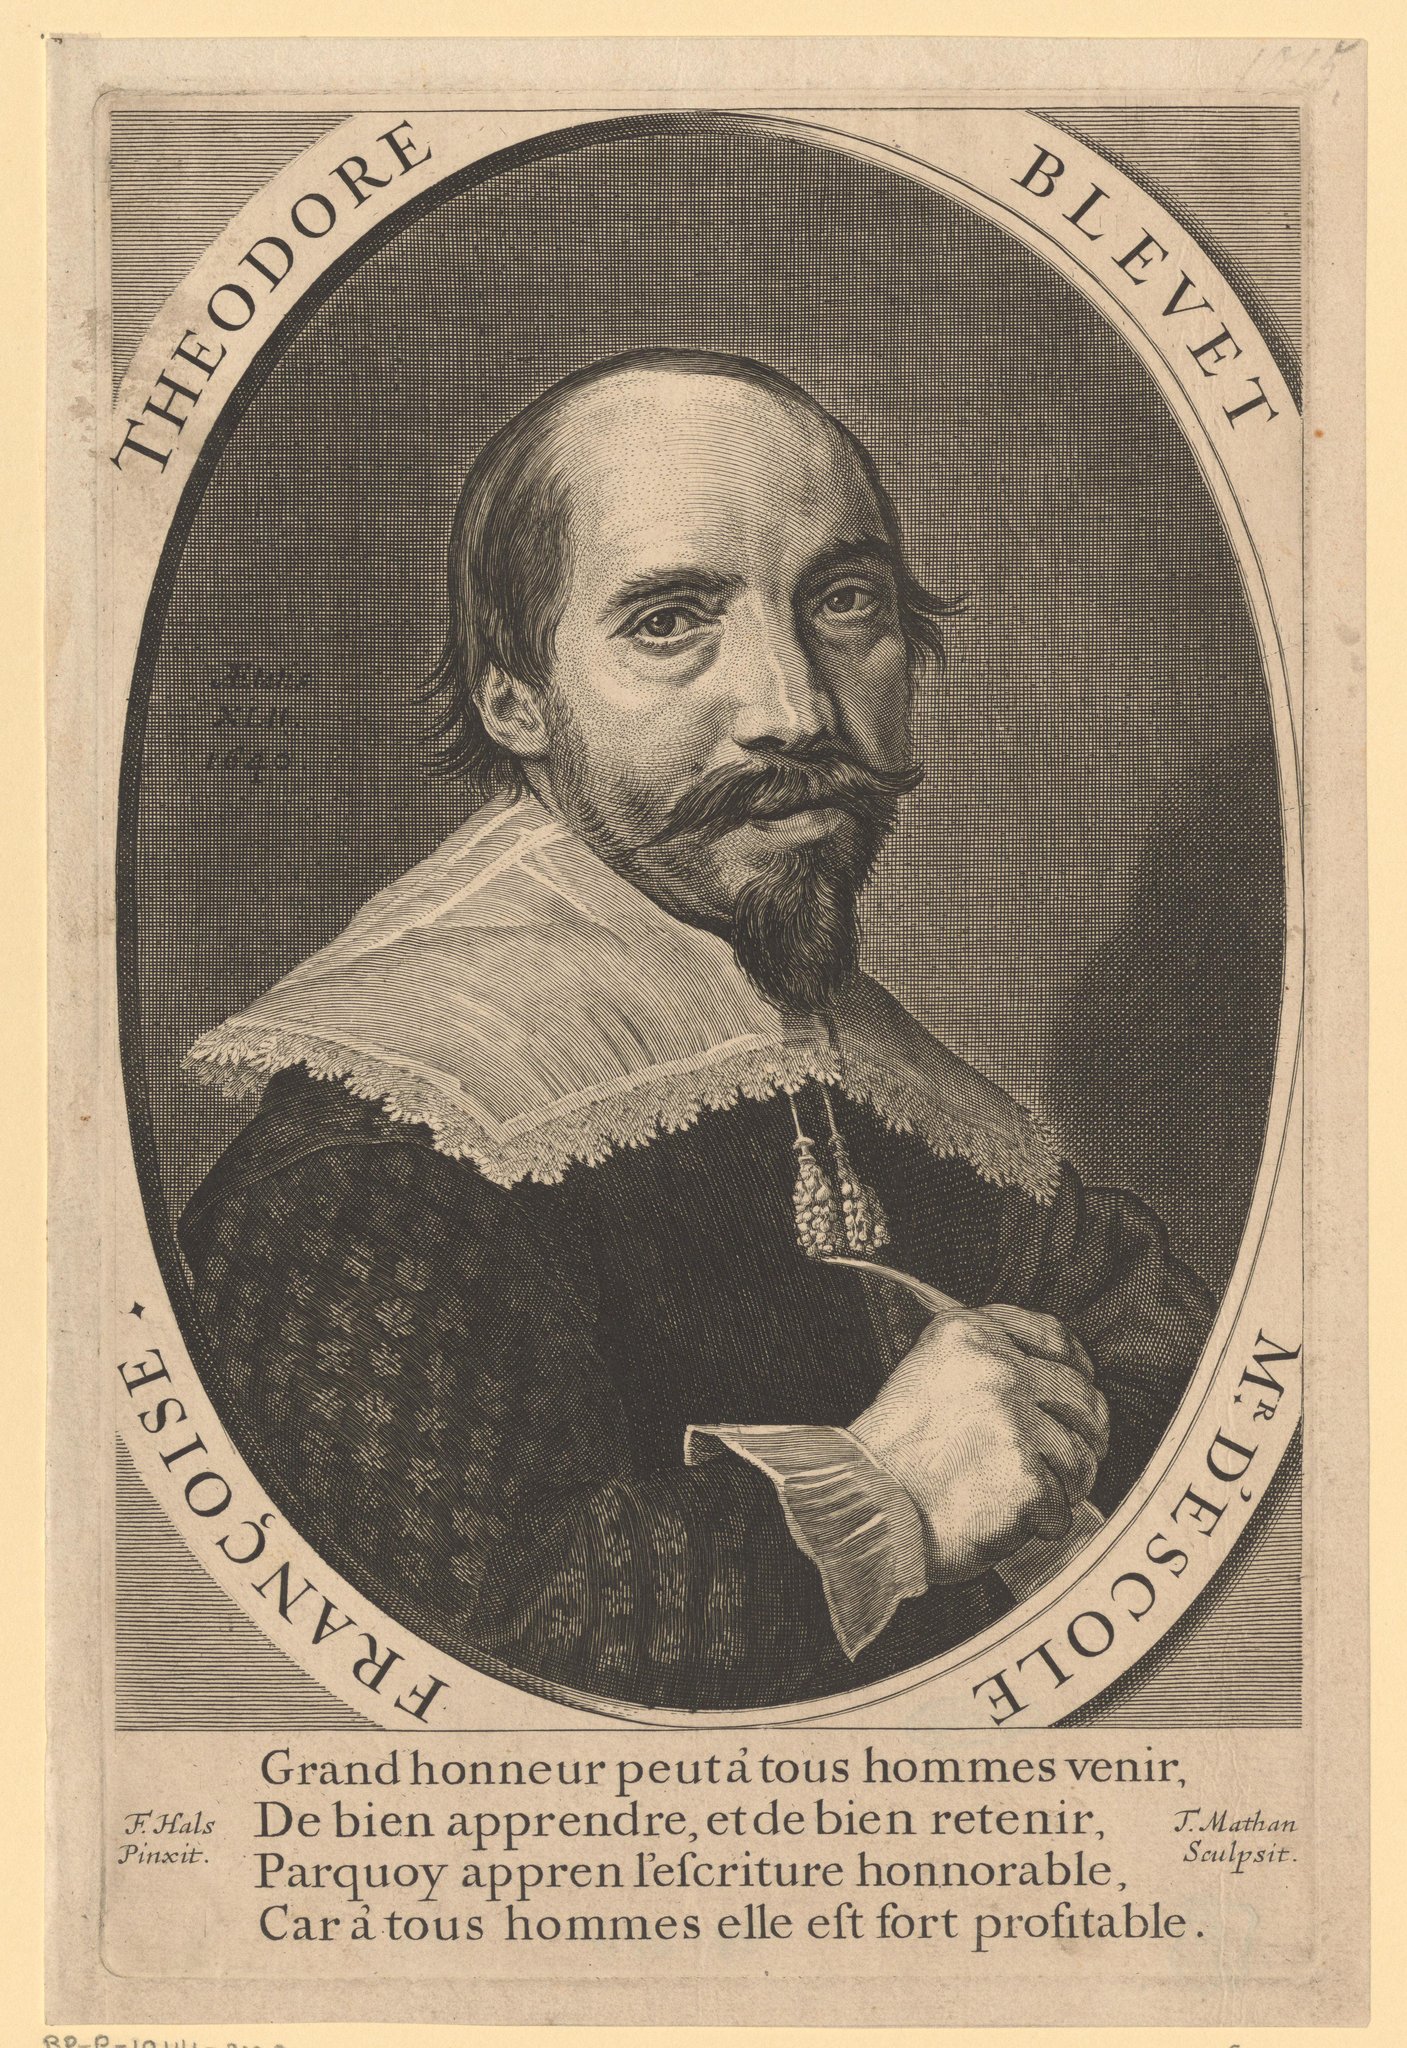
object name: print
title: Portret van Theodore Bleuet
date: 1640-1676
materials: paper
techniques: engraving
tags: quill, historical persons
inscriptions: collector's mark: Lugt 963, collector's mark: Lugt 2228